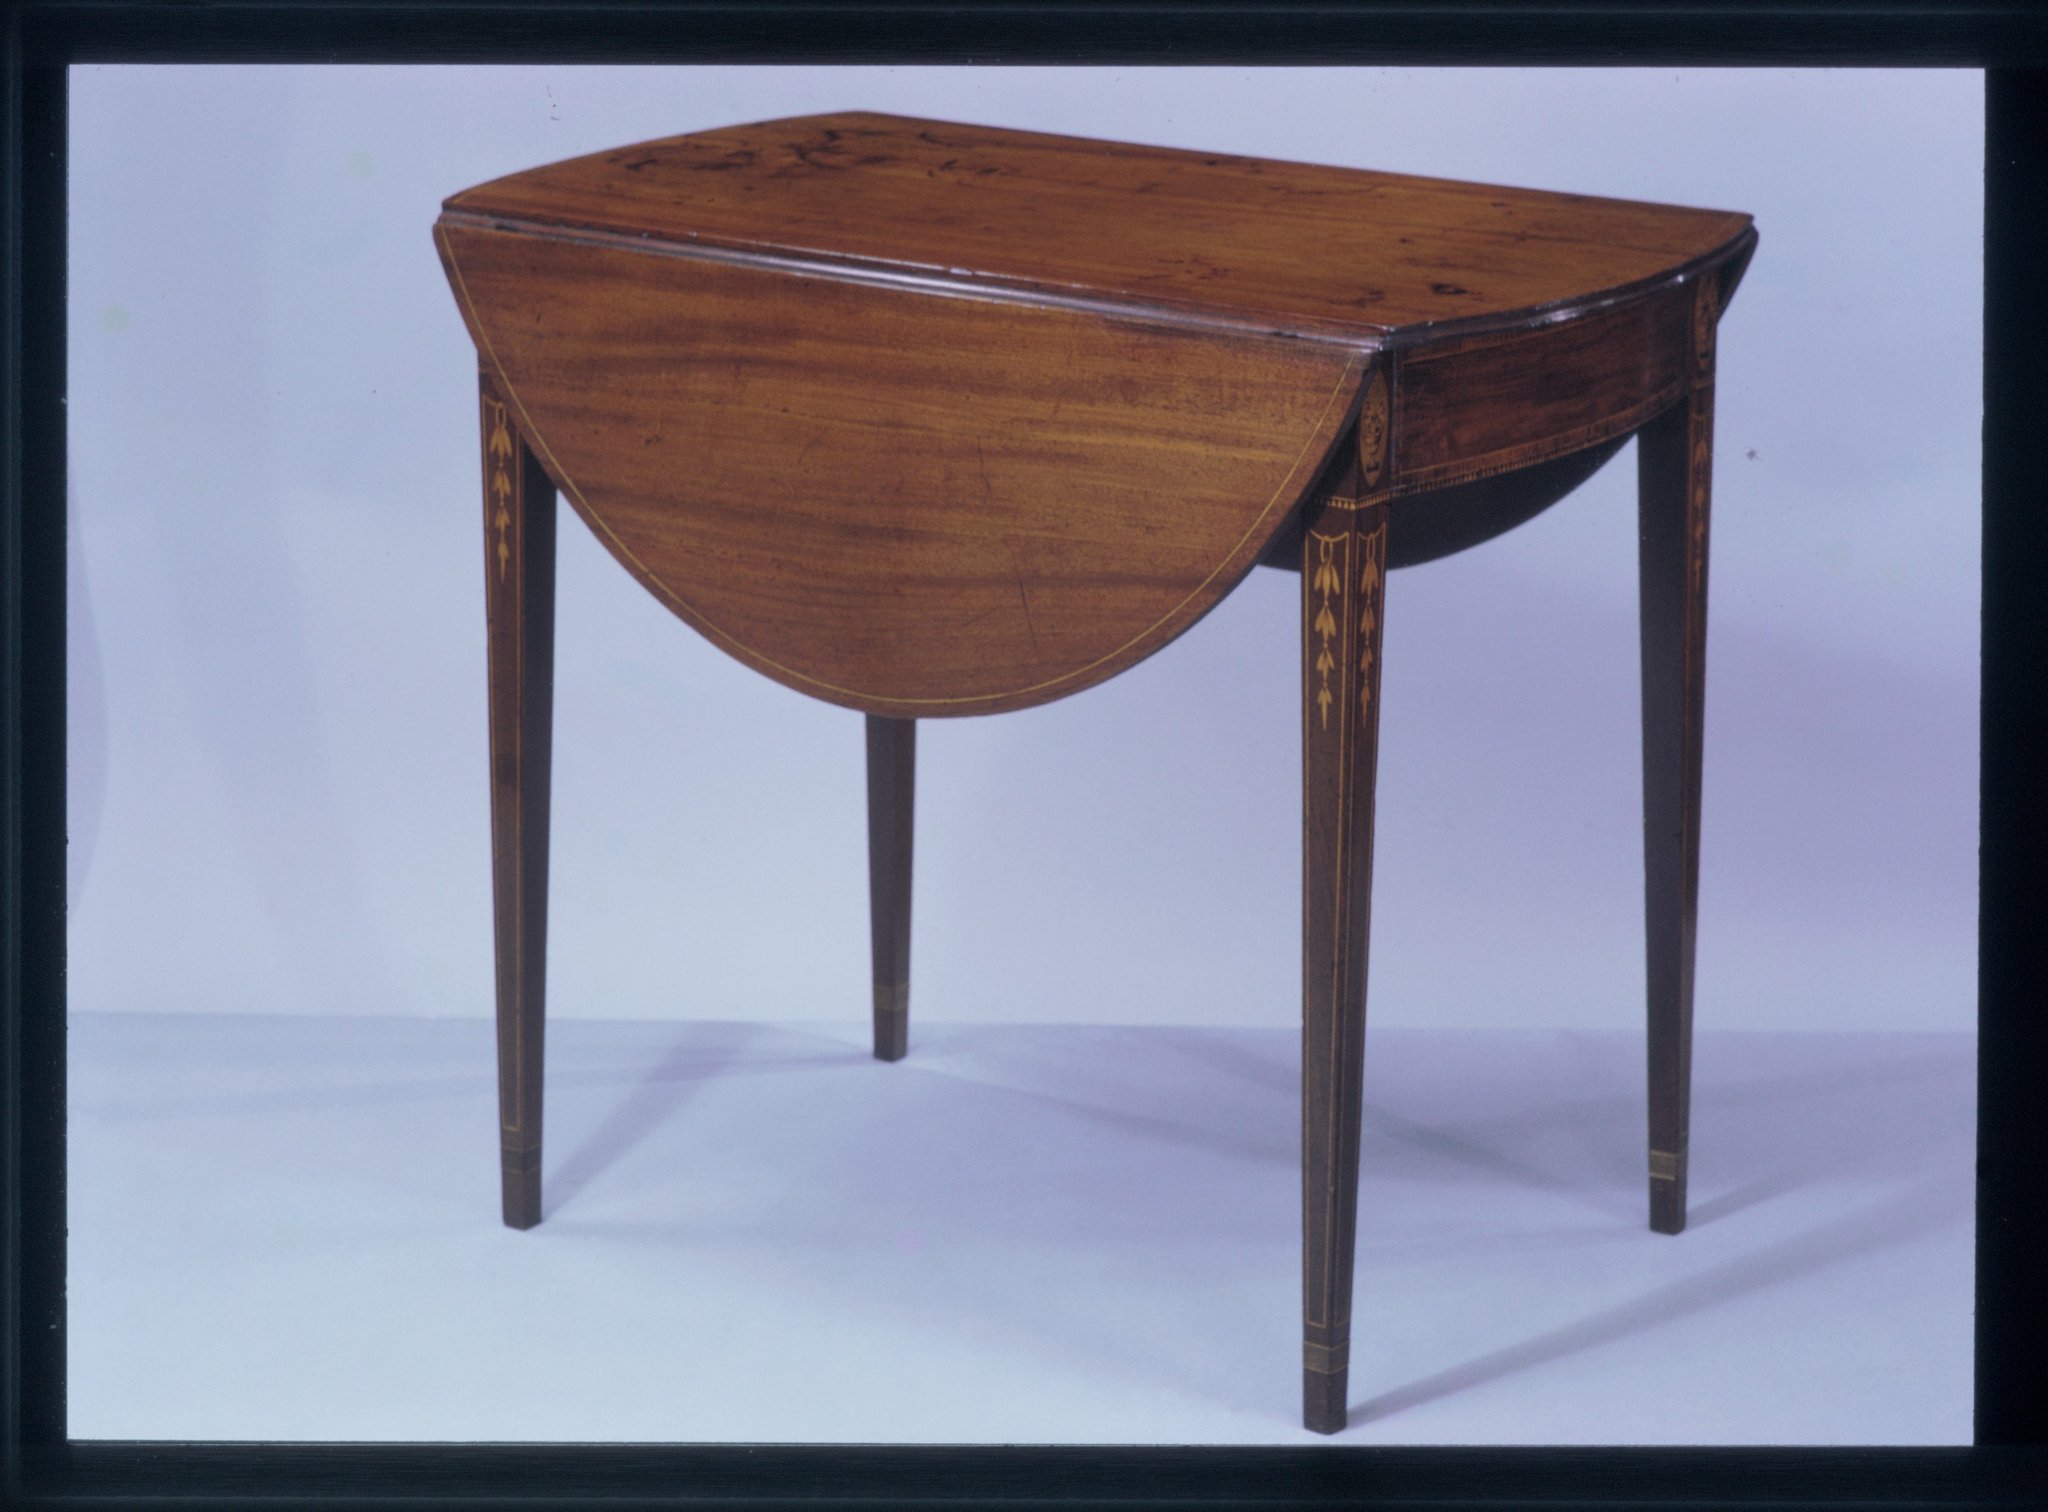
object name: drop leaf pembroke table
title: Drop-leaf Pembroke Table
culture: american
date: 1800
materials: wood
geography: united states